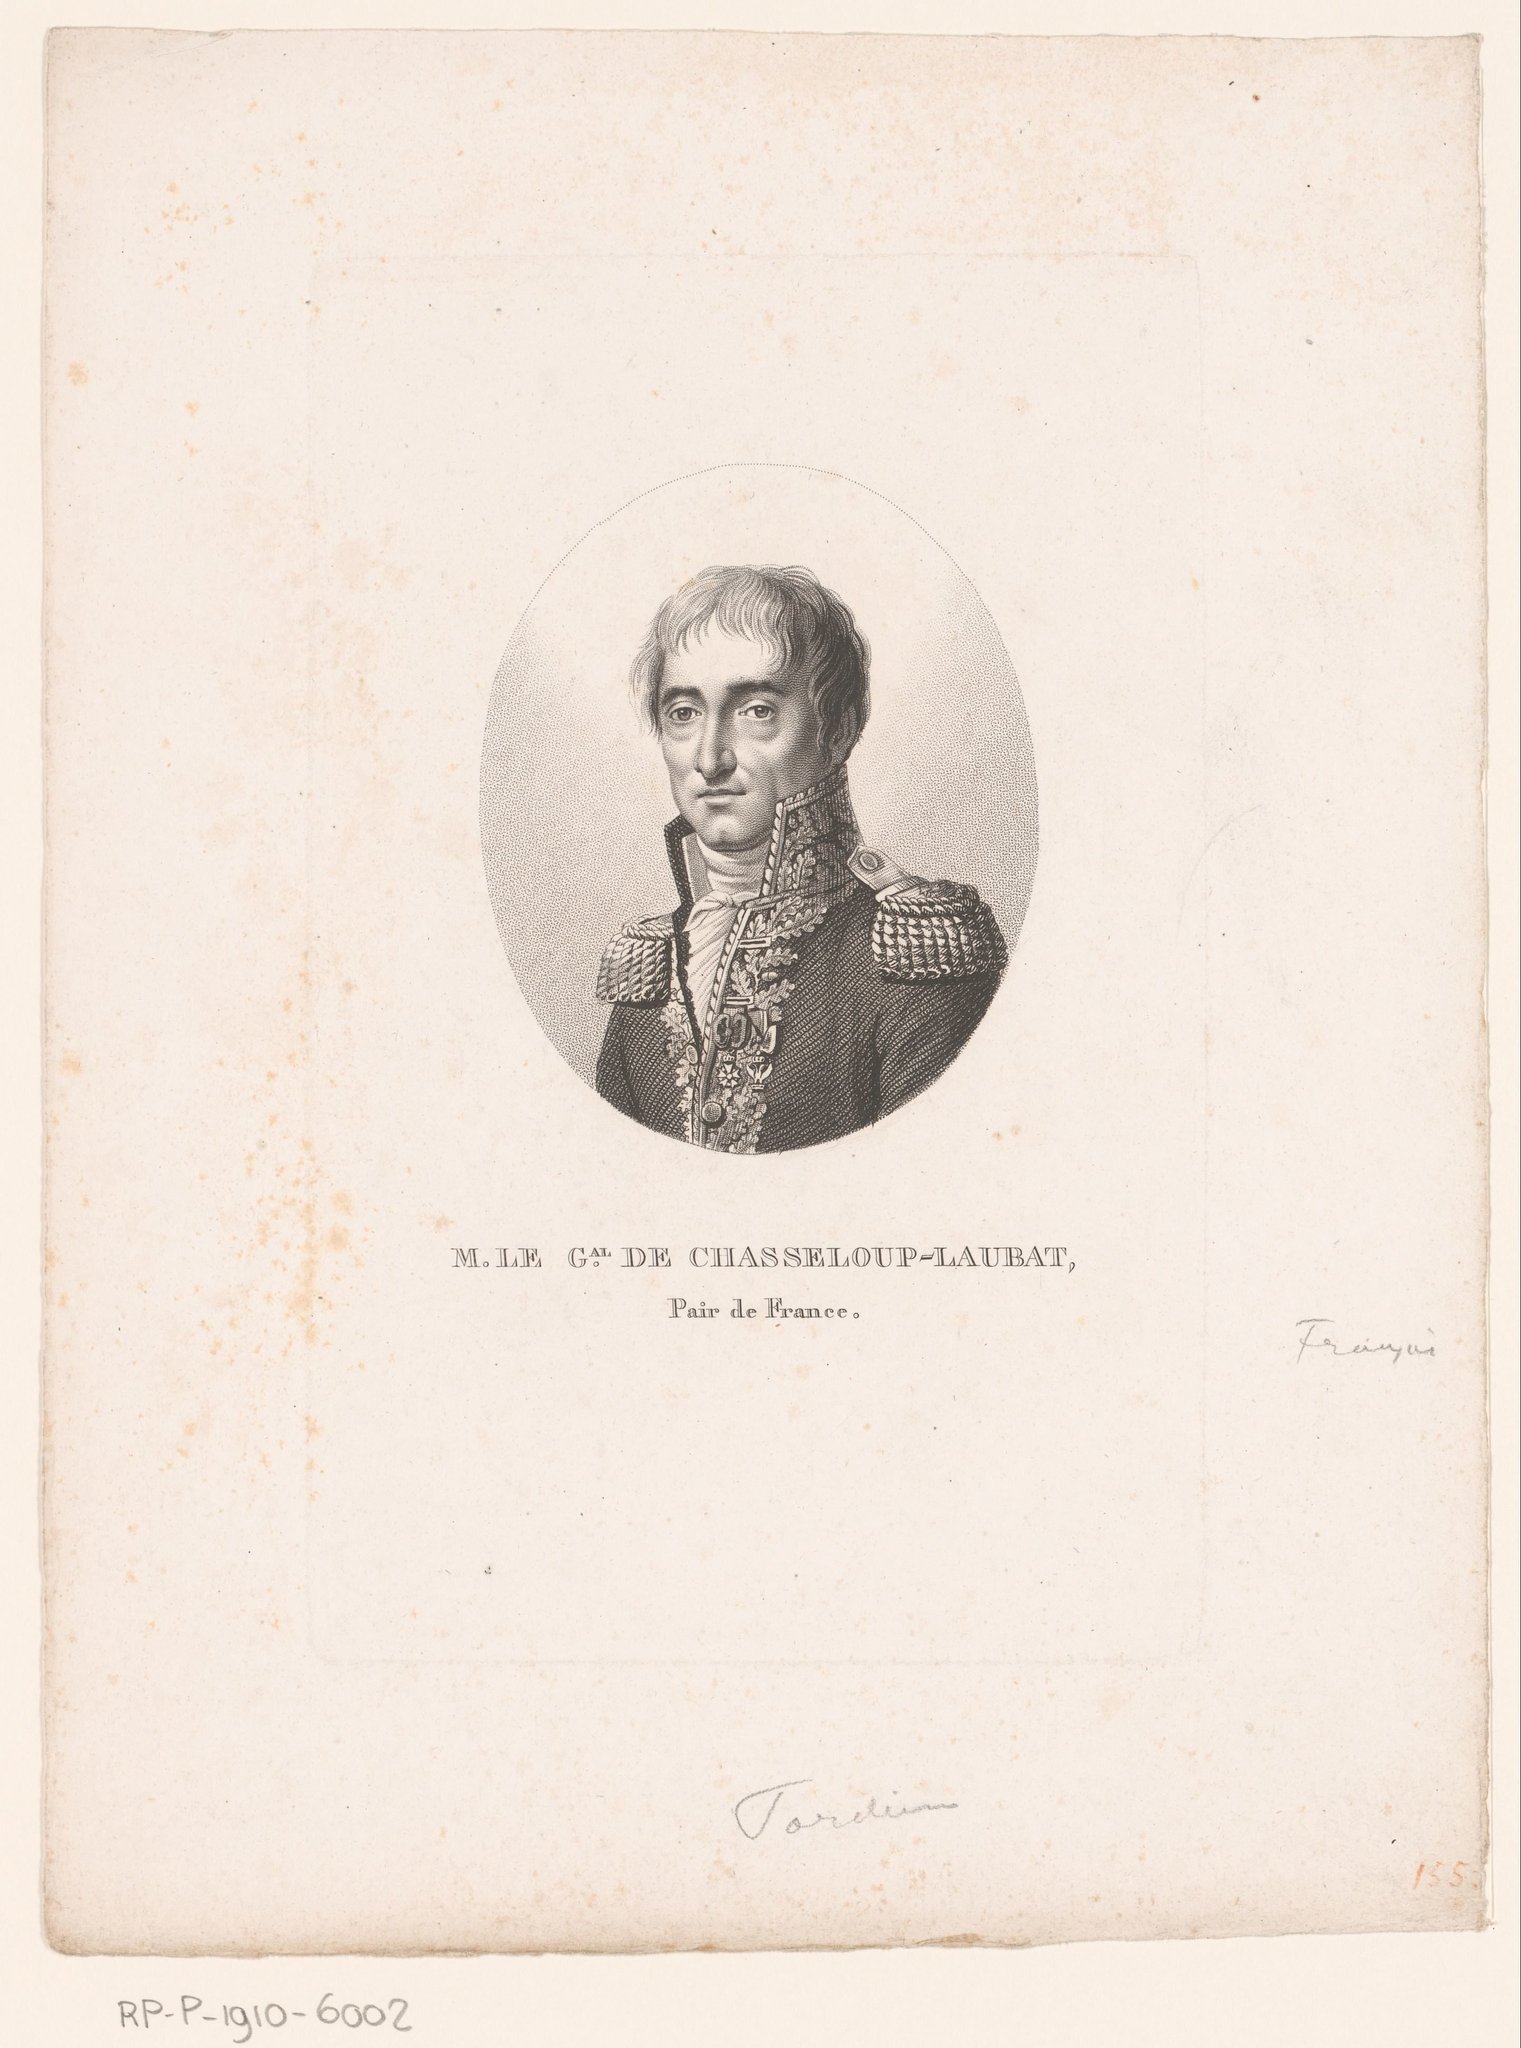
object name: book illustration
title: Portret van François de Chasseloup-Laubat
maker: ambroise tardieu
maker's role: print maker, printer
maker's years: 1788-1841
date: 1820-1821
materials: paper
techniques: engraving, etching, roulette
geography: paris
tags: ranks in the army, historical persons, politician, e.g. party leader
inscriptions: collector's mark: Lugt 2228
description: Prent uit: Tardieu, Ambroise. Portraits des députés, écrivains et pairs constitutionnels, défenseurs invariables de la charte et de la loi des élections du 5 février 1817. Parijs: Tardieu, Ambroise, 1820-1821.